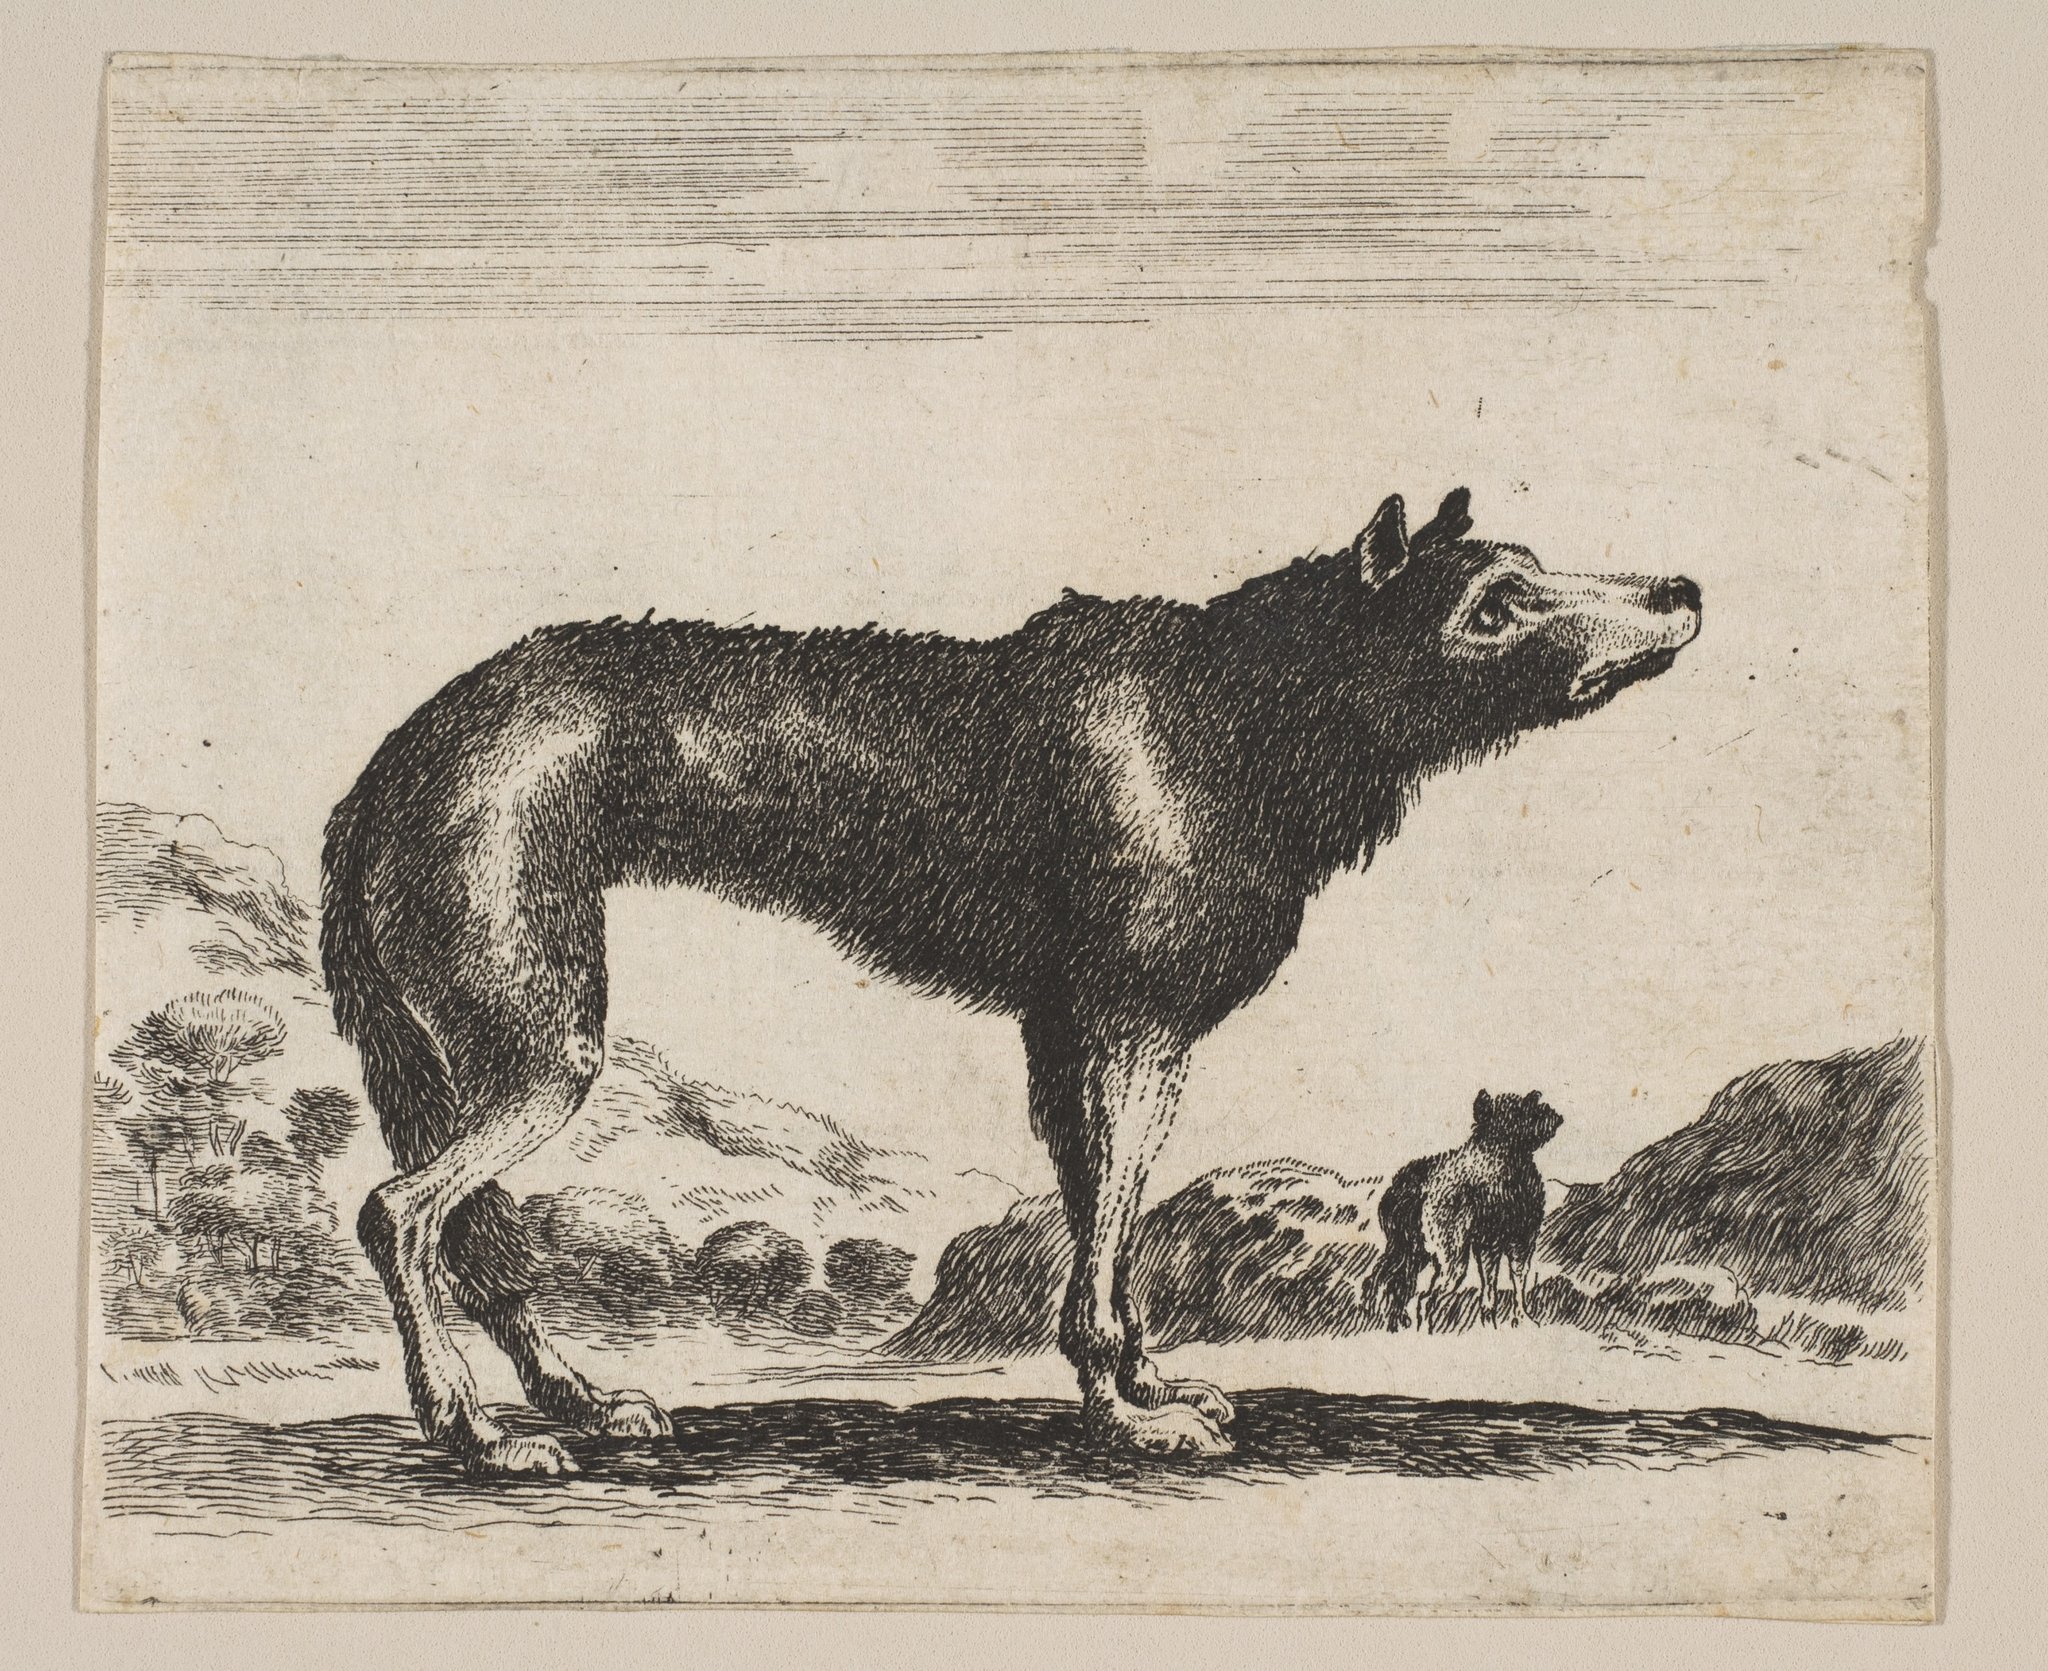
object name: print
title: Plate 20: Wolf, from "Various animals" (Diversi animali)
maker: anonymous, 17th century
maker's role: printmaker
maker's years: 1600-1700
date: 1641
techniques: etching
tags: animals